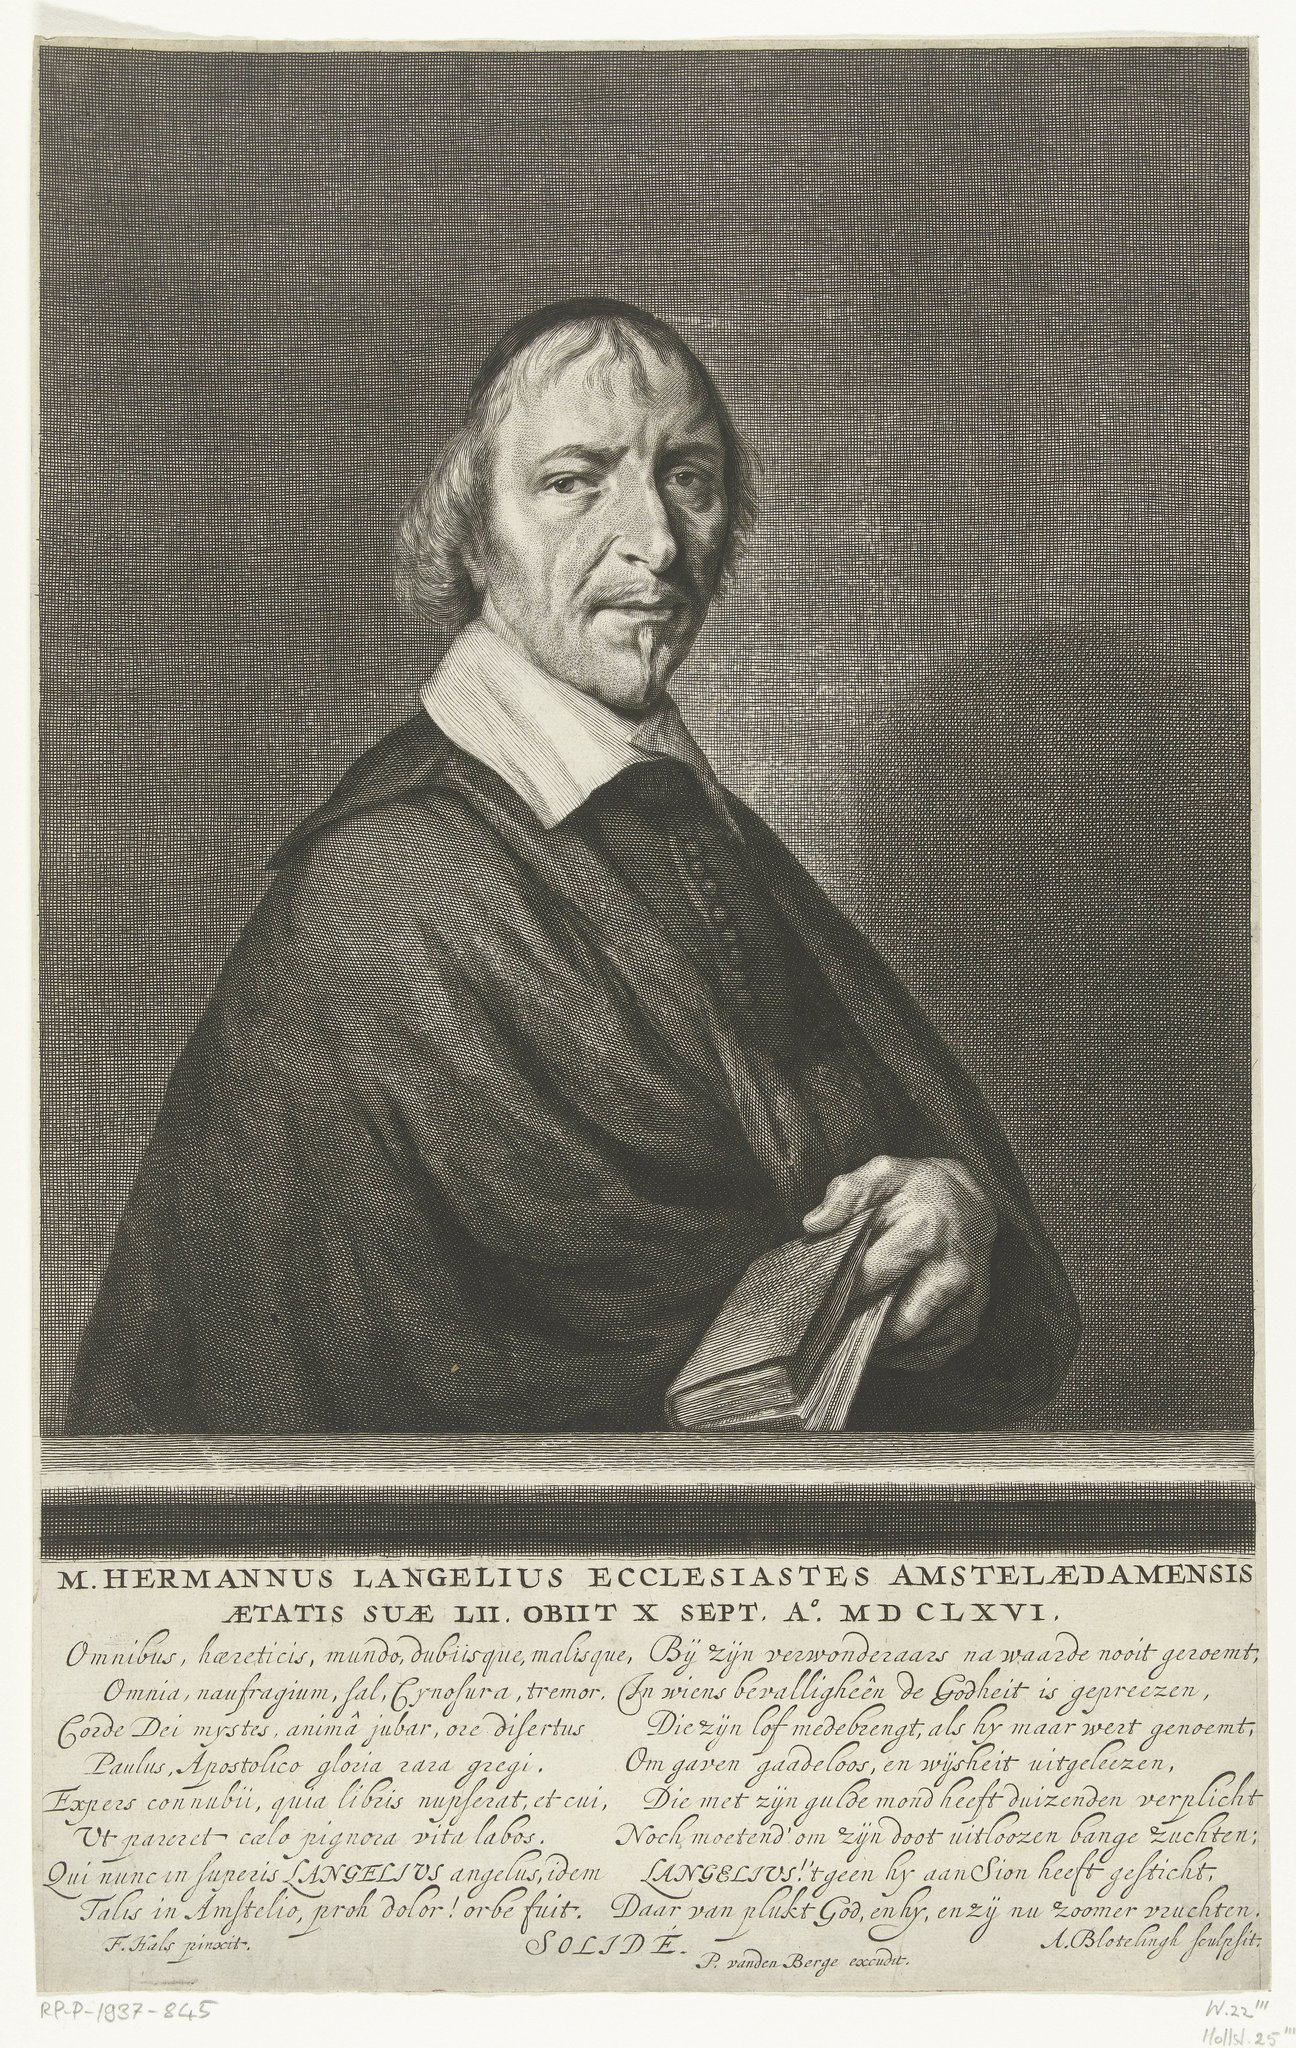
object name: print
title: M. Hermannus Langelius Ecclesiastes Amstelædamensis (...)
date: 1666-1690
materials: paper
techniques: engraving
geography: amsterdam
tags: predikant, hermanus langelius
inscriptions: collector's mark: Lugt 2228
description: Portret van de Amsterdamse predikant Hermanus Langelius, met een boek in zijn hand. Onder het portret een vers in het Latijn en Nederlands op Langelius werk in Amsterdam.